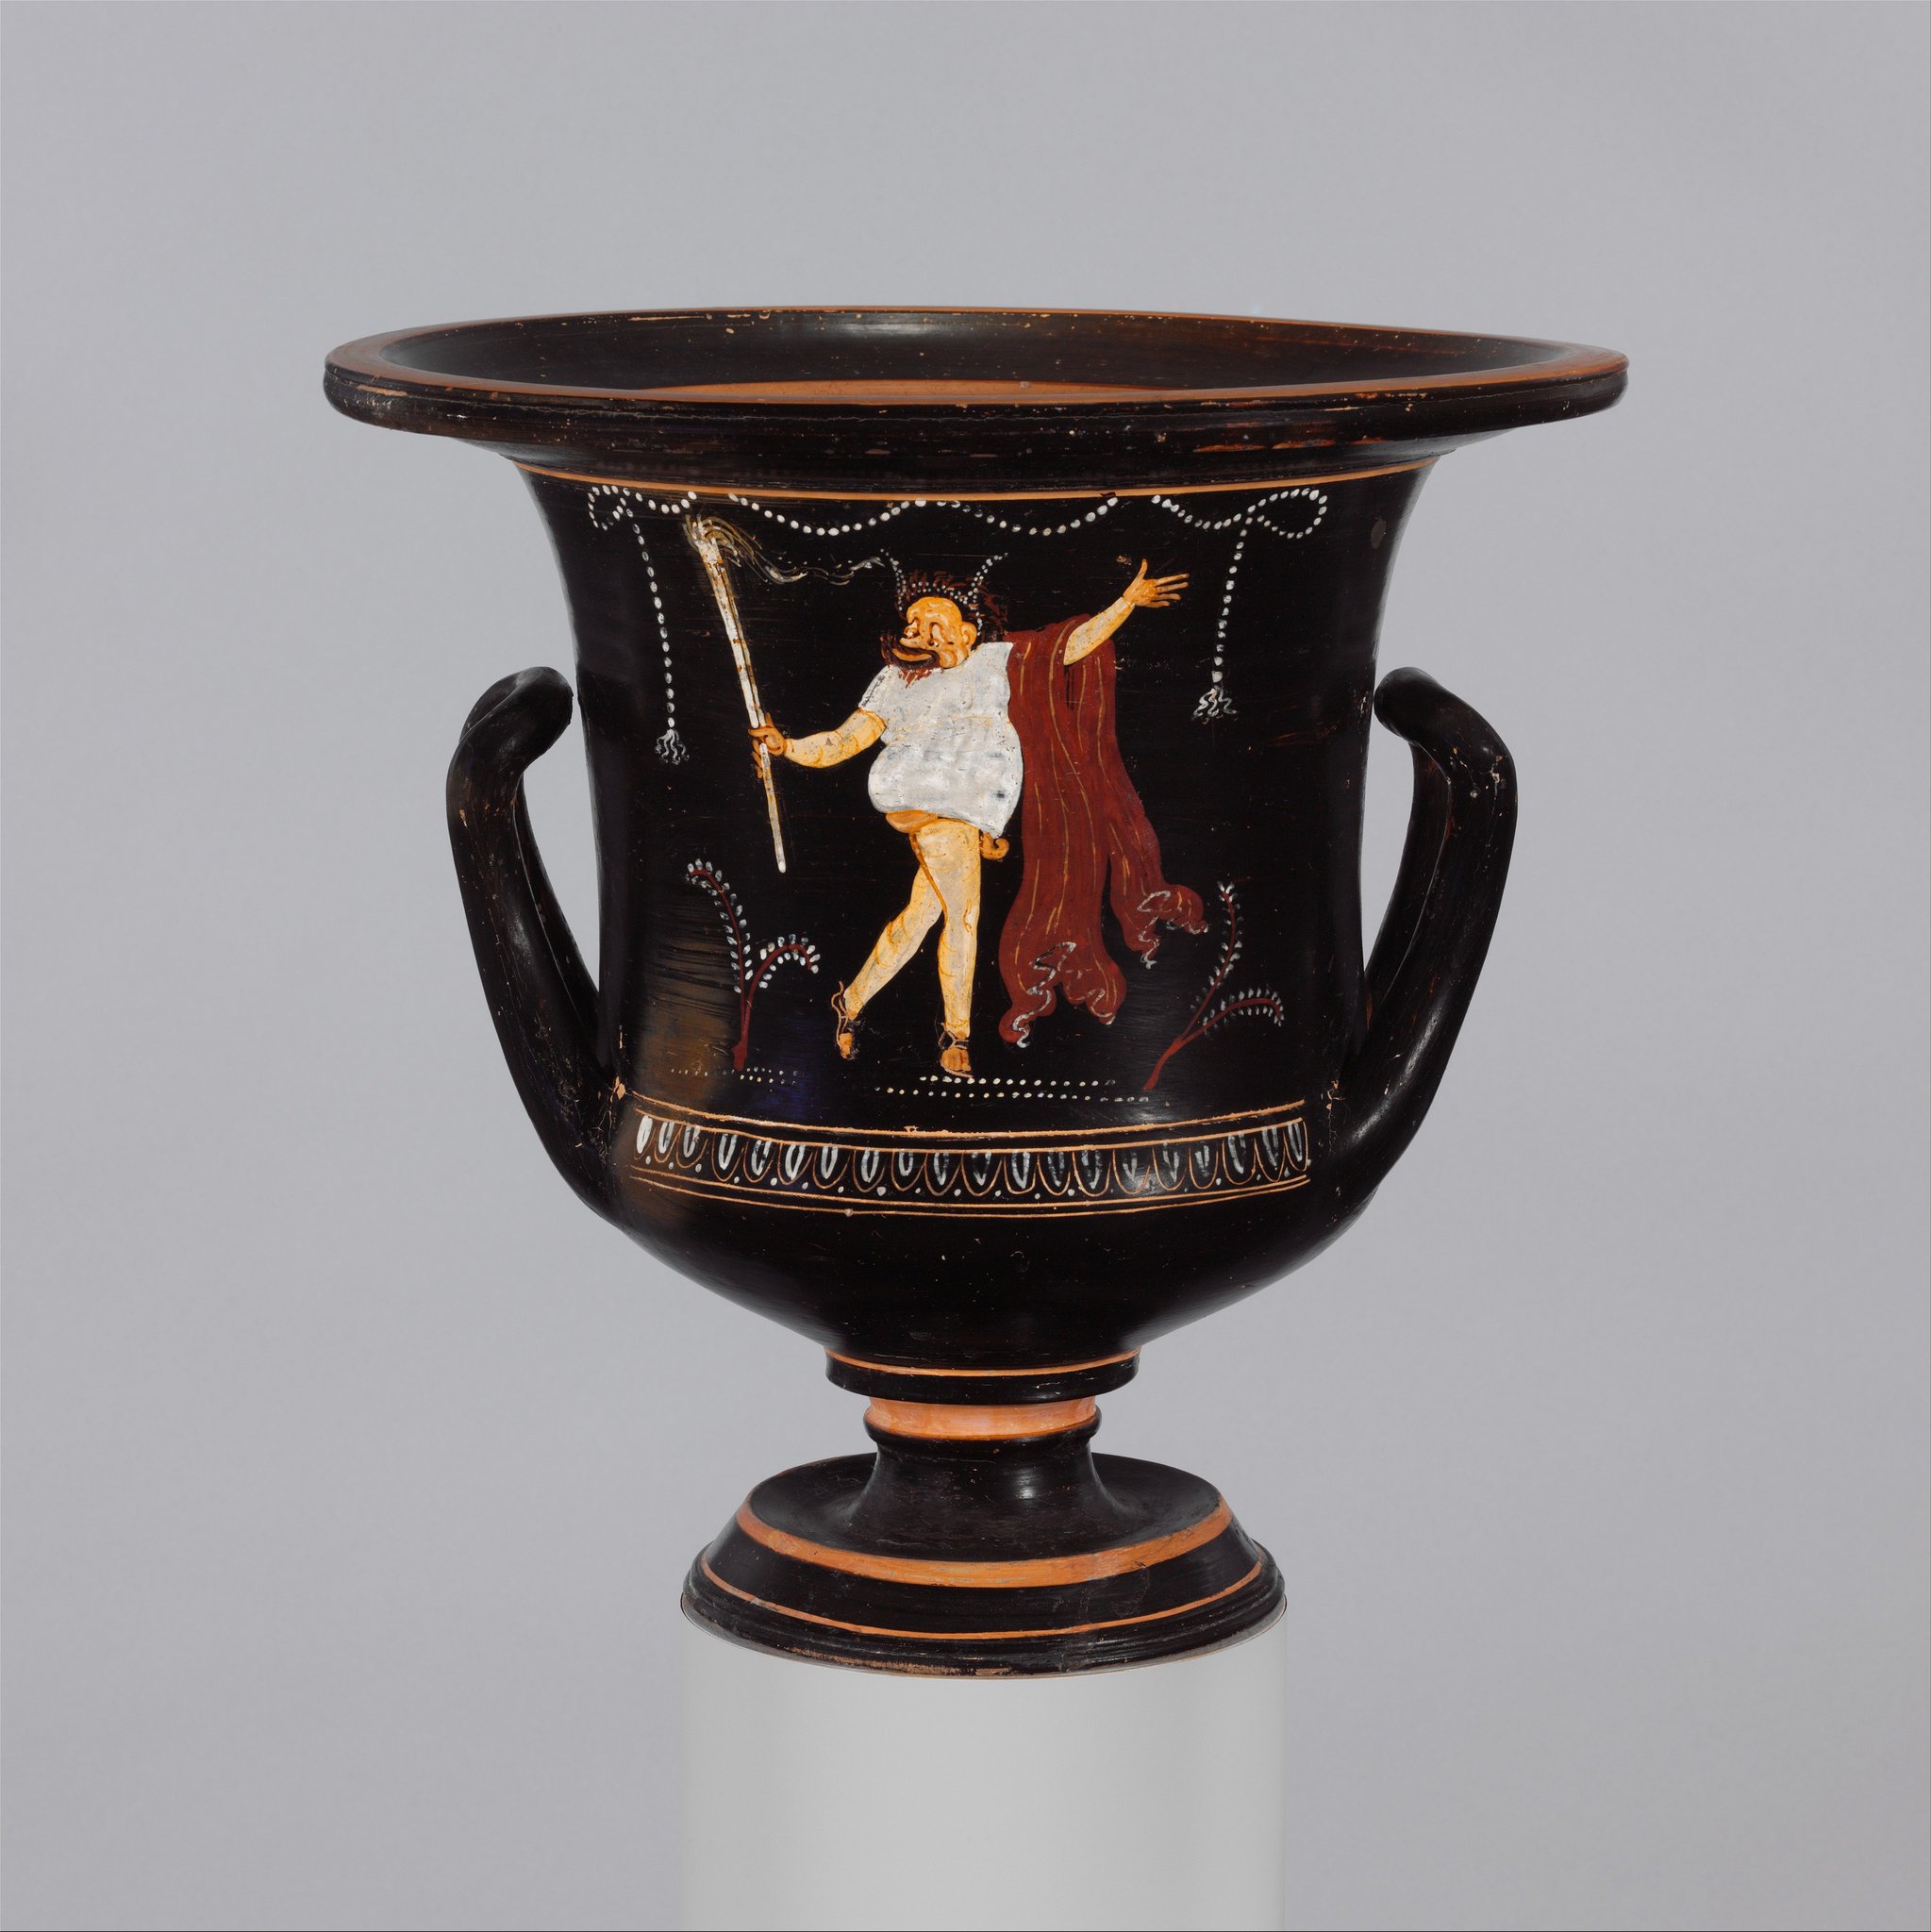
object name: calyx krater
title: Terracotta calyx-krater (mixing bowl)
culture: greek, south italian, apulian, gnathian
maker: konnakis group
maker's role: artist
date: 350-325 BCE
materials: terracotta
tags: men,actors